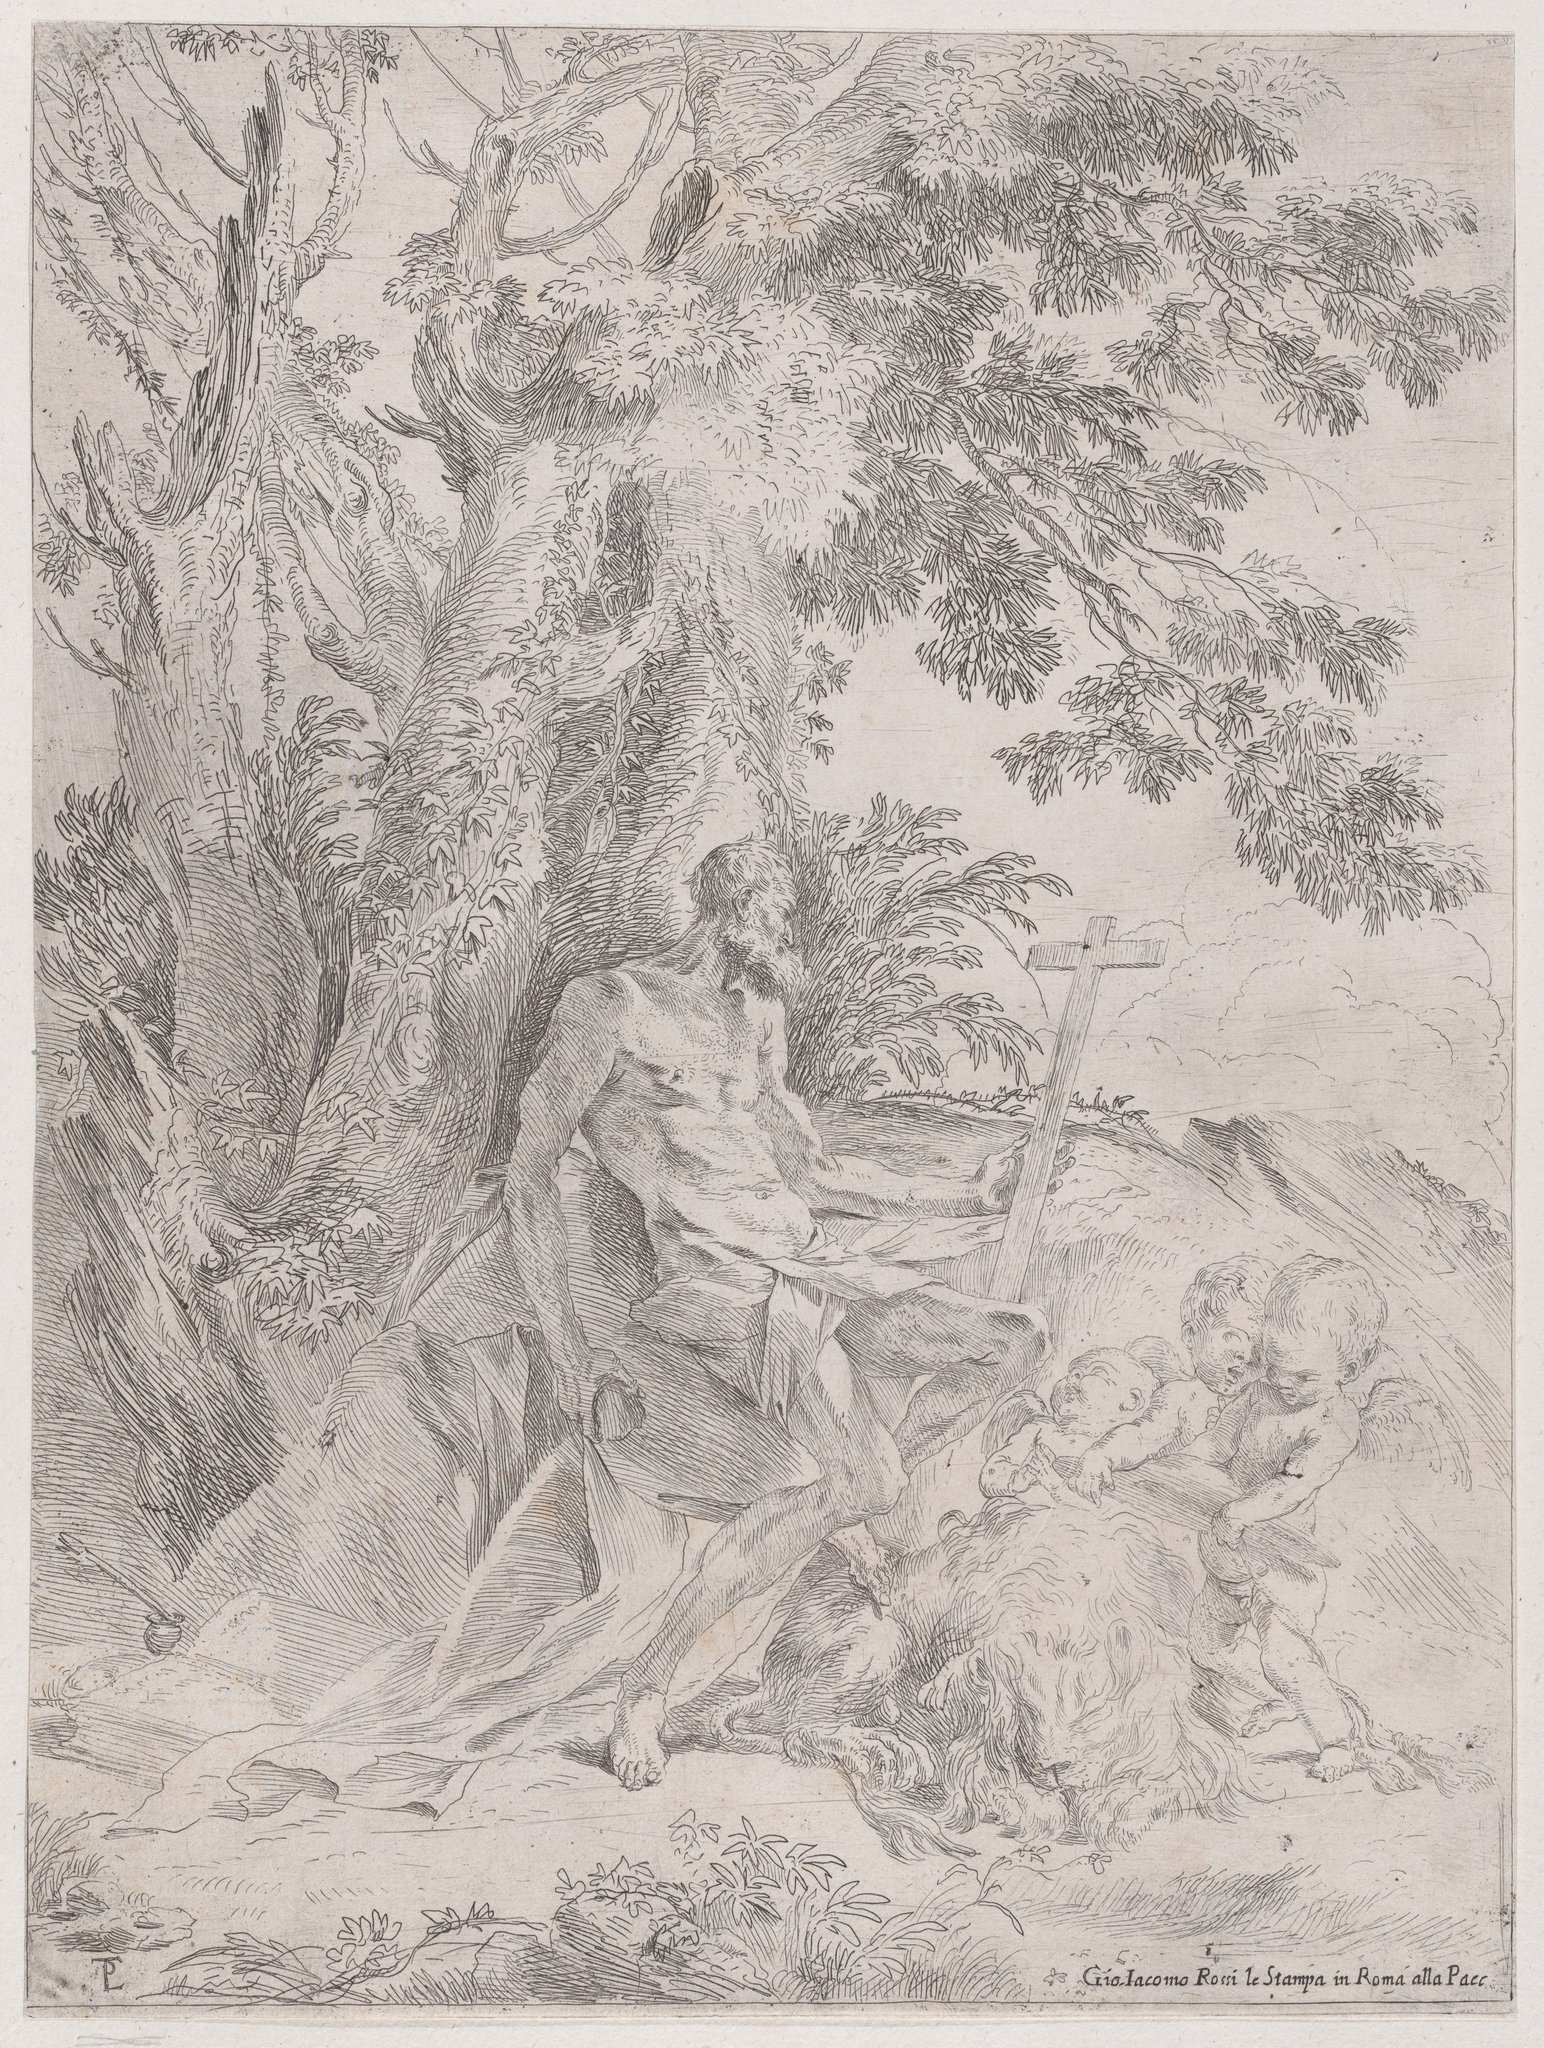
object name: print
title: Saint Jerome before a crucifix accompanied by a lion and three putti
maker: pietro testa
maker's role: artist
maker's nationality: italian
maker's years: 1612-1650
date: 1631-1637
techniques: etching